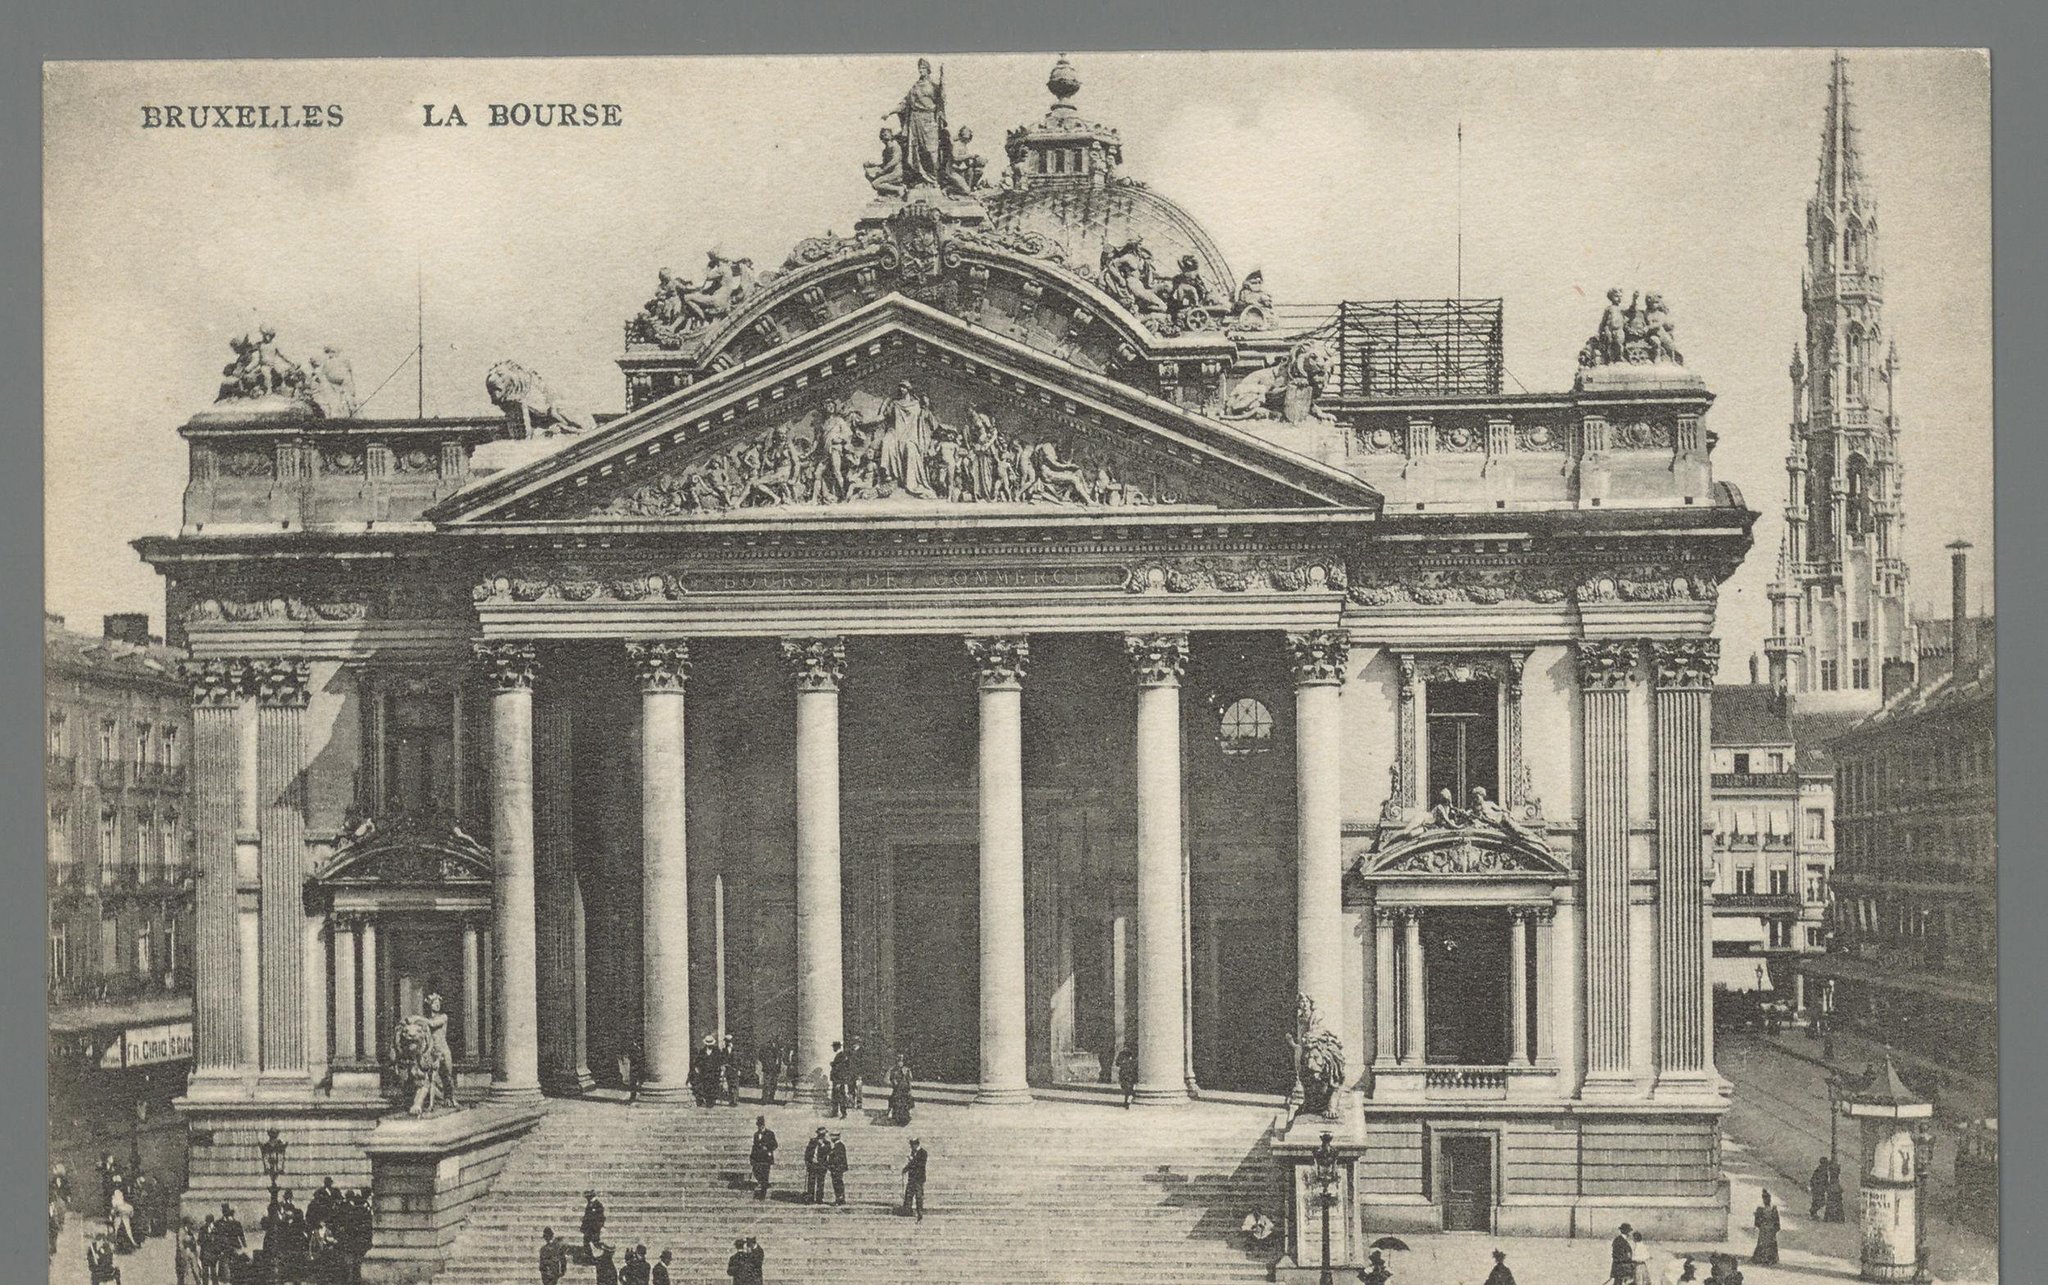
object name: photomechanical print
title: Bruxelles. La Bourse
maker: Anonymous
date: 1906-1930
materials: cardboard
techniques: photograph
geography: brussels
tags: exchange, bourse, city-view, and landscape with man-made constructions (+ city(-scape) with figures, staffage)